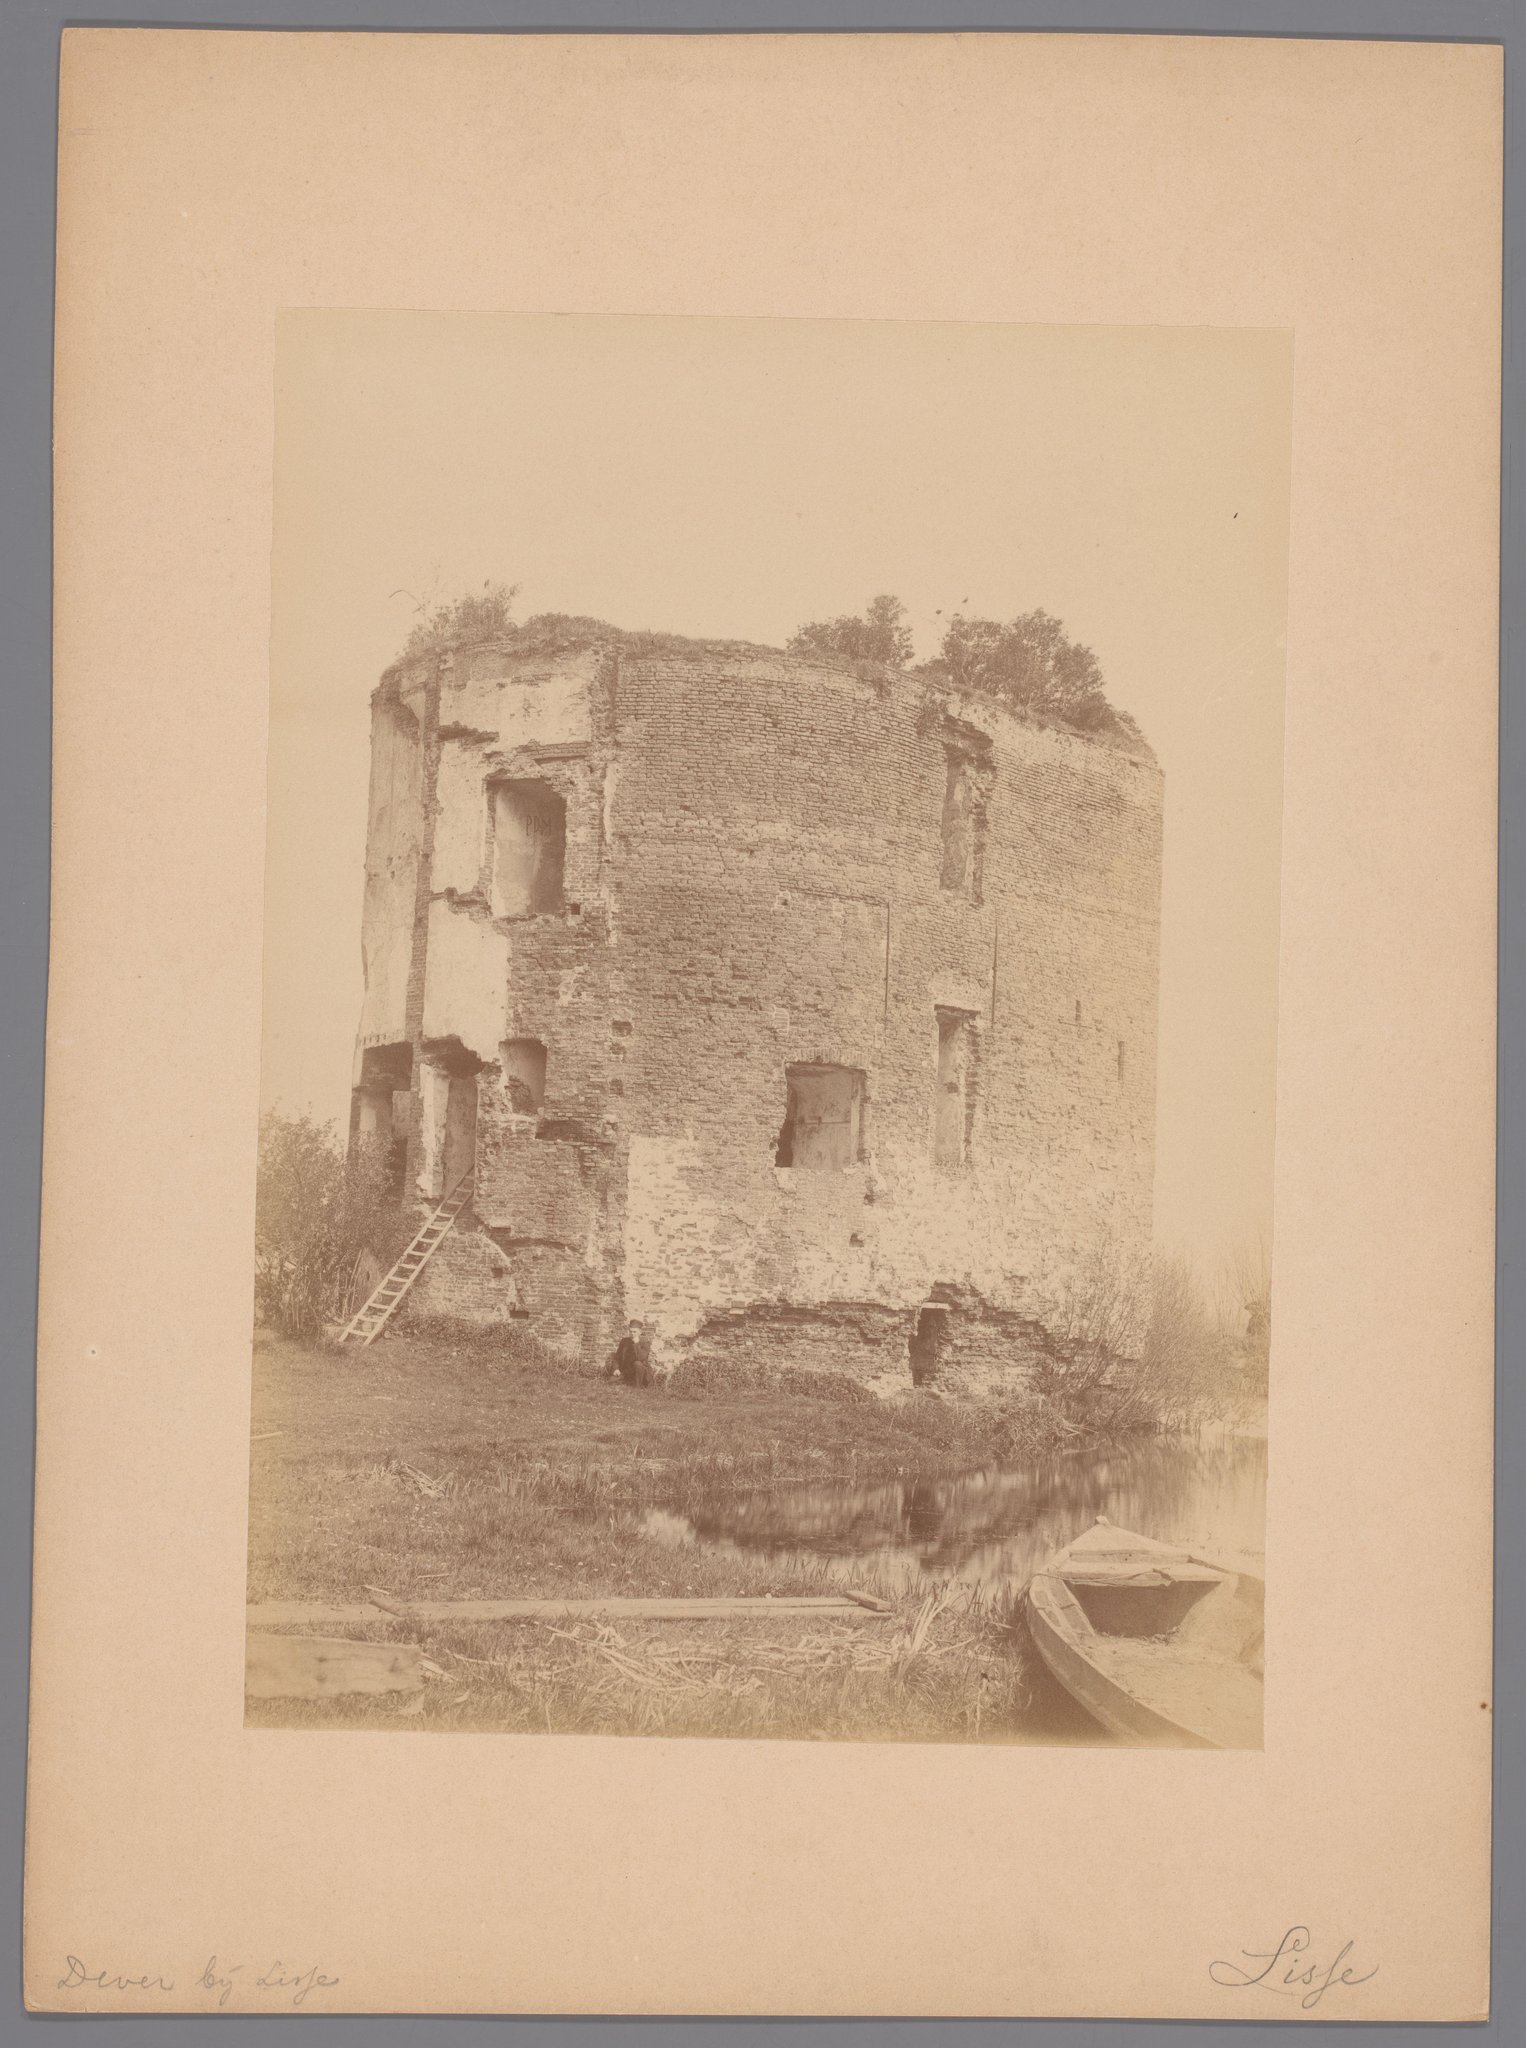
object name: photograph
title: Gezicht op 't Huys Dever te Lisse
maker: anoniem (monumentenzorg)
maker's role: fotograaf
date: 1890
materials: cardboard, photographic support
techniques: albumen print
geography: lisse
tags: castle, landscape with ruins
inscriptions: annotation: ‘Dever bij Lisse/ Lisse’, annotation: ‘Het huis Dever bij Lisse/ Mei 1890’